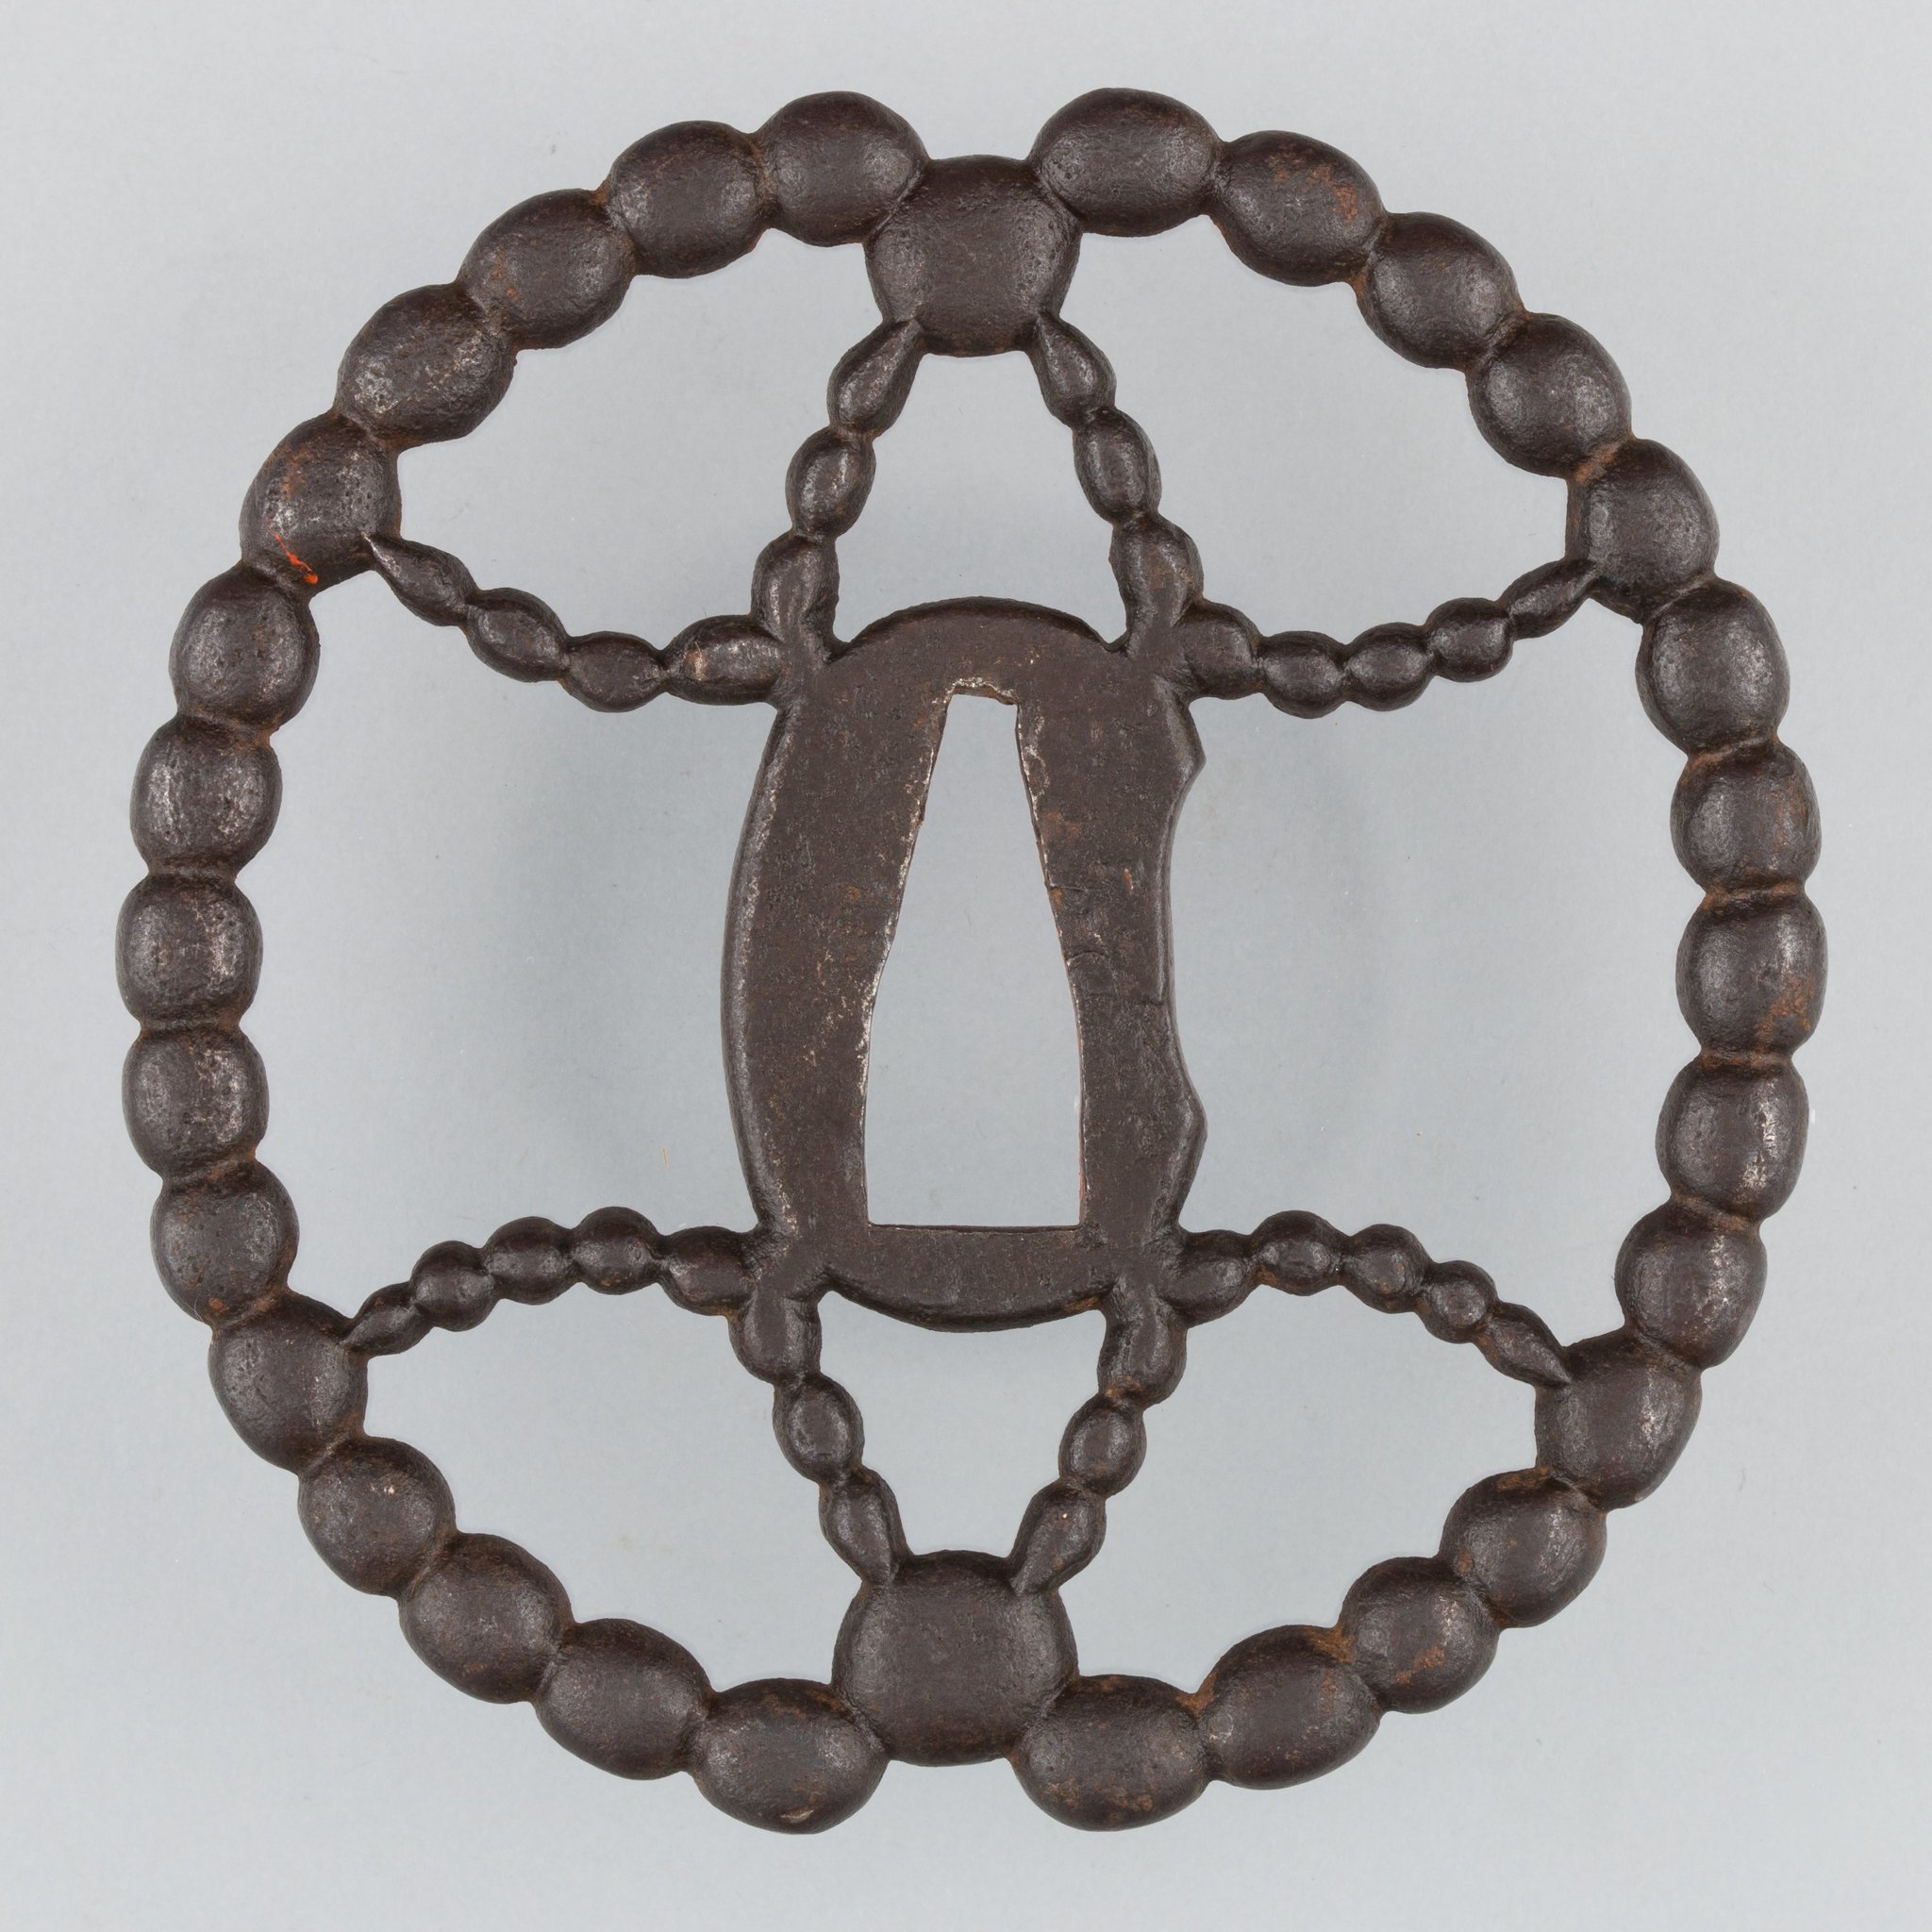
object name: sword guard tsuba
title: Sword Guard (Tsuba)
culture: japanese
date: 1567-1633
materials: copper, iron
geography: japan